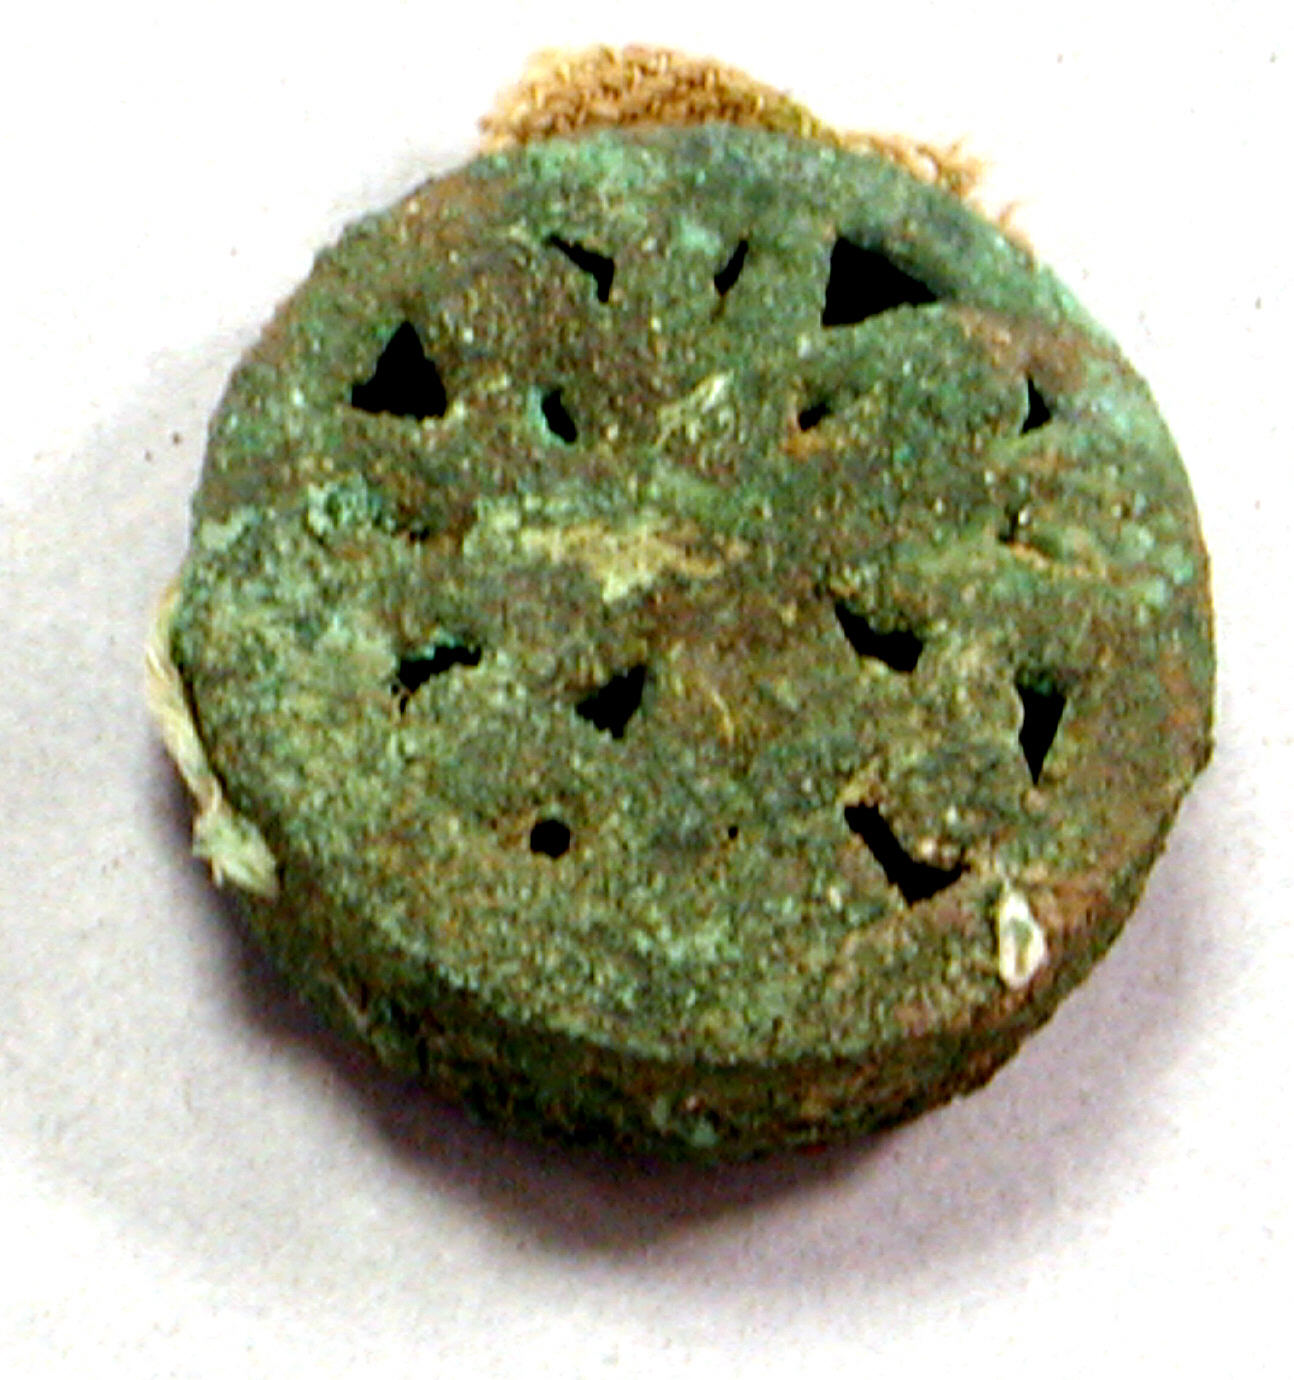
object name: bead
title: Openwork Copper Bead with Bird Design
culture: chimú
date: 1101-1500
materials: copper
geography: peru